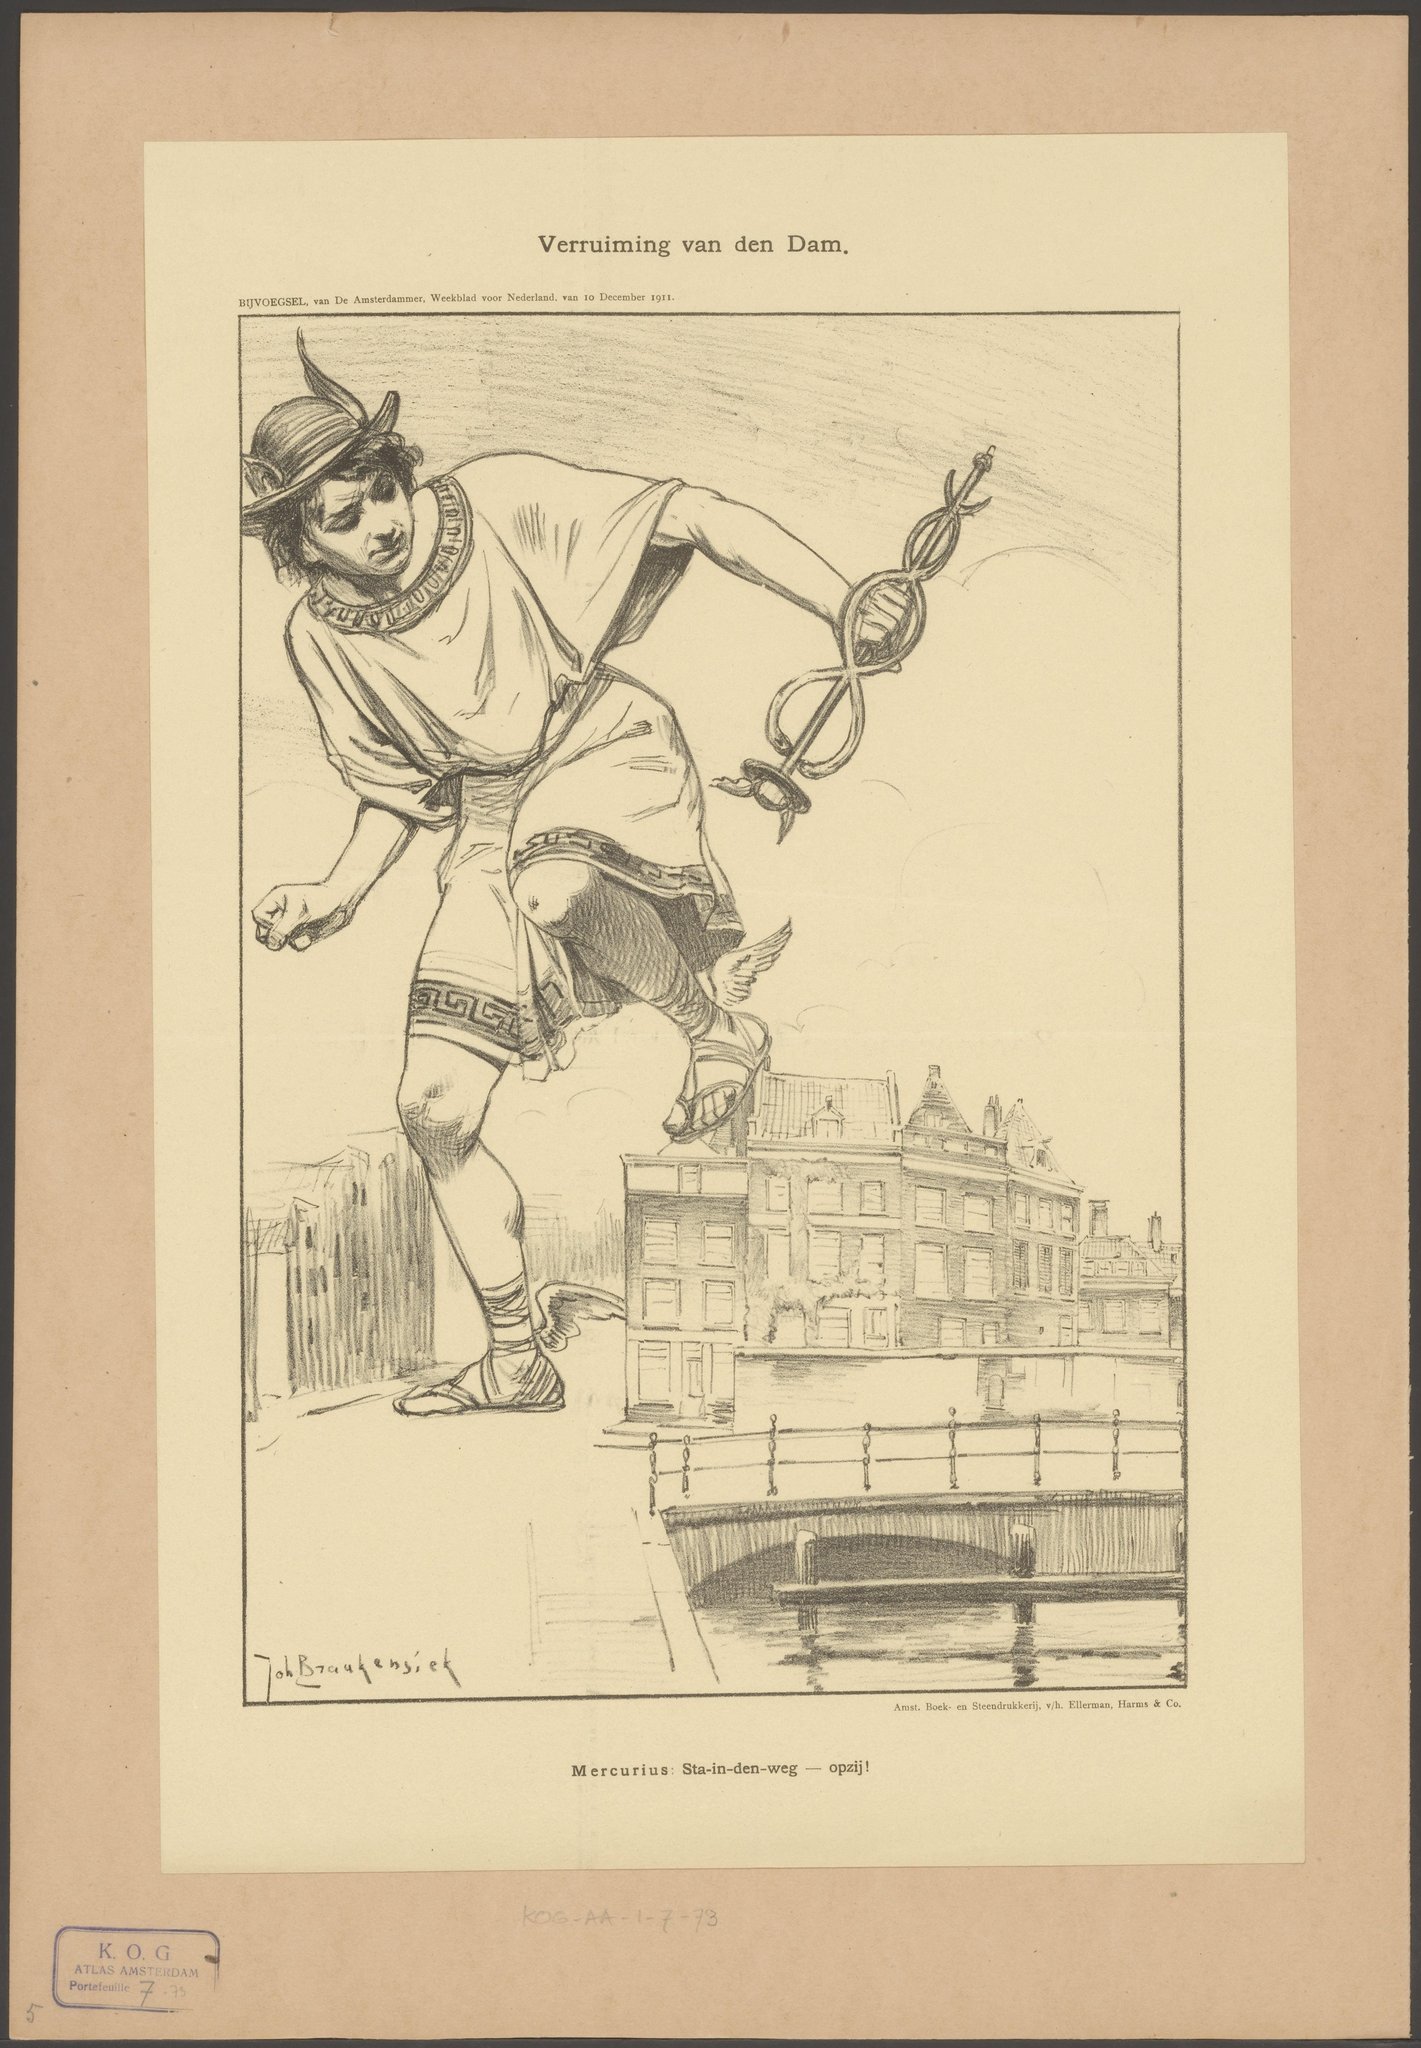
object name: cartoon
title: Verruiming van den Dam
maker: johan braakensiek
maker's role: draughtsman, print maker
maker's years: 1858-1940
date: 1911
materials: paper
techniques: letterpress printing, lithograph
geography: amsterdam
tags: square, place, circus, etc., city-view in general; 'veduta', demolition of building, specific aspects, allegorical aspects of mercury; mercury as patron, political caricatures and satires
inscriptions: collector's mark: ‘7’ Lugt 1641b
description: Bijvoegsel uit: De Groene Amsterdammer (1911), 10 december 1911.